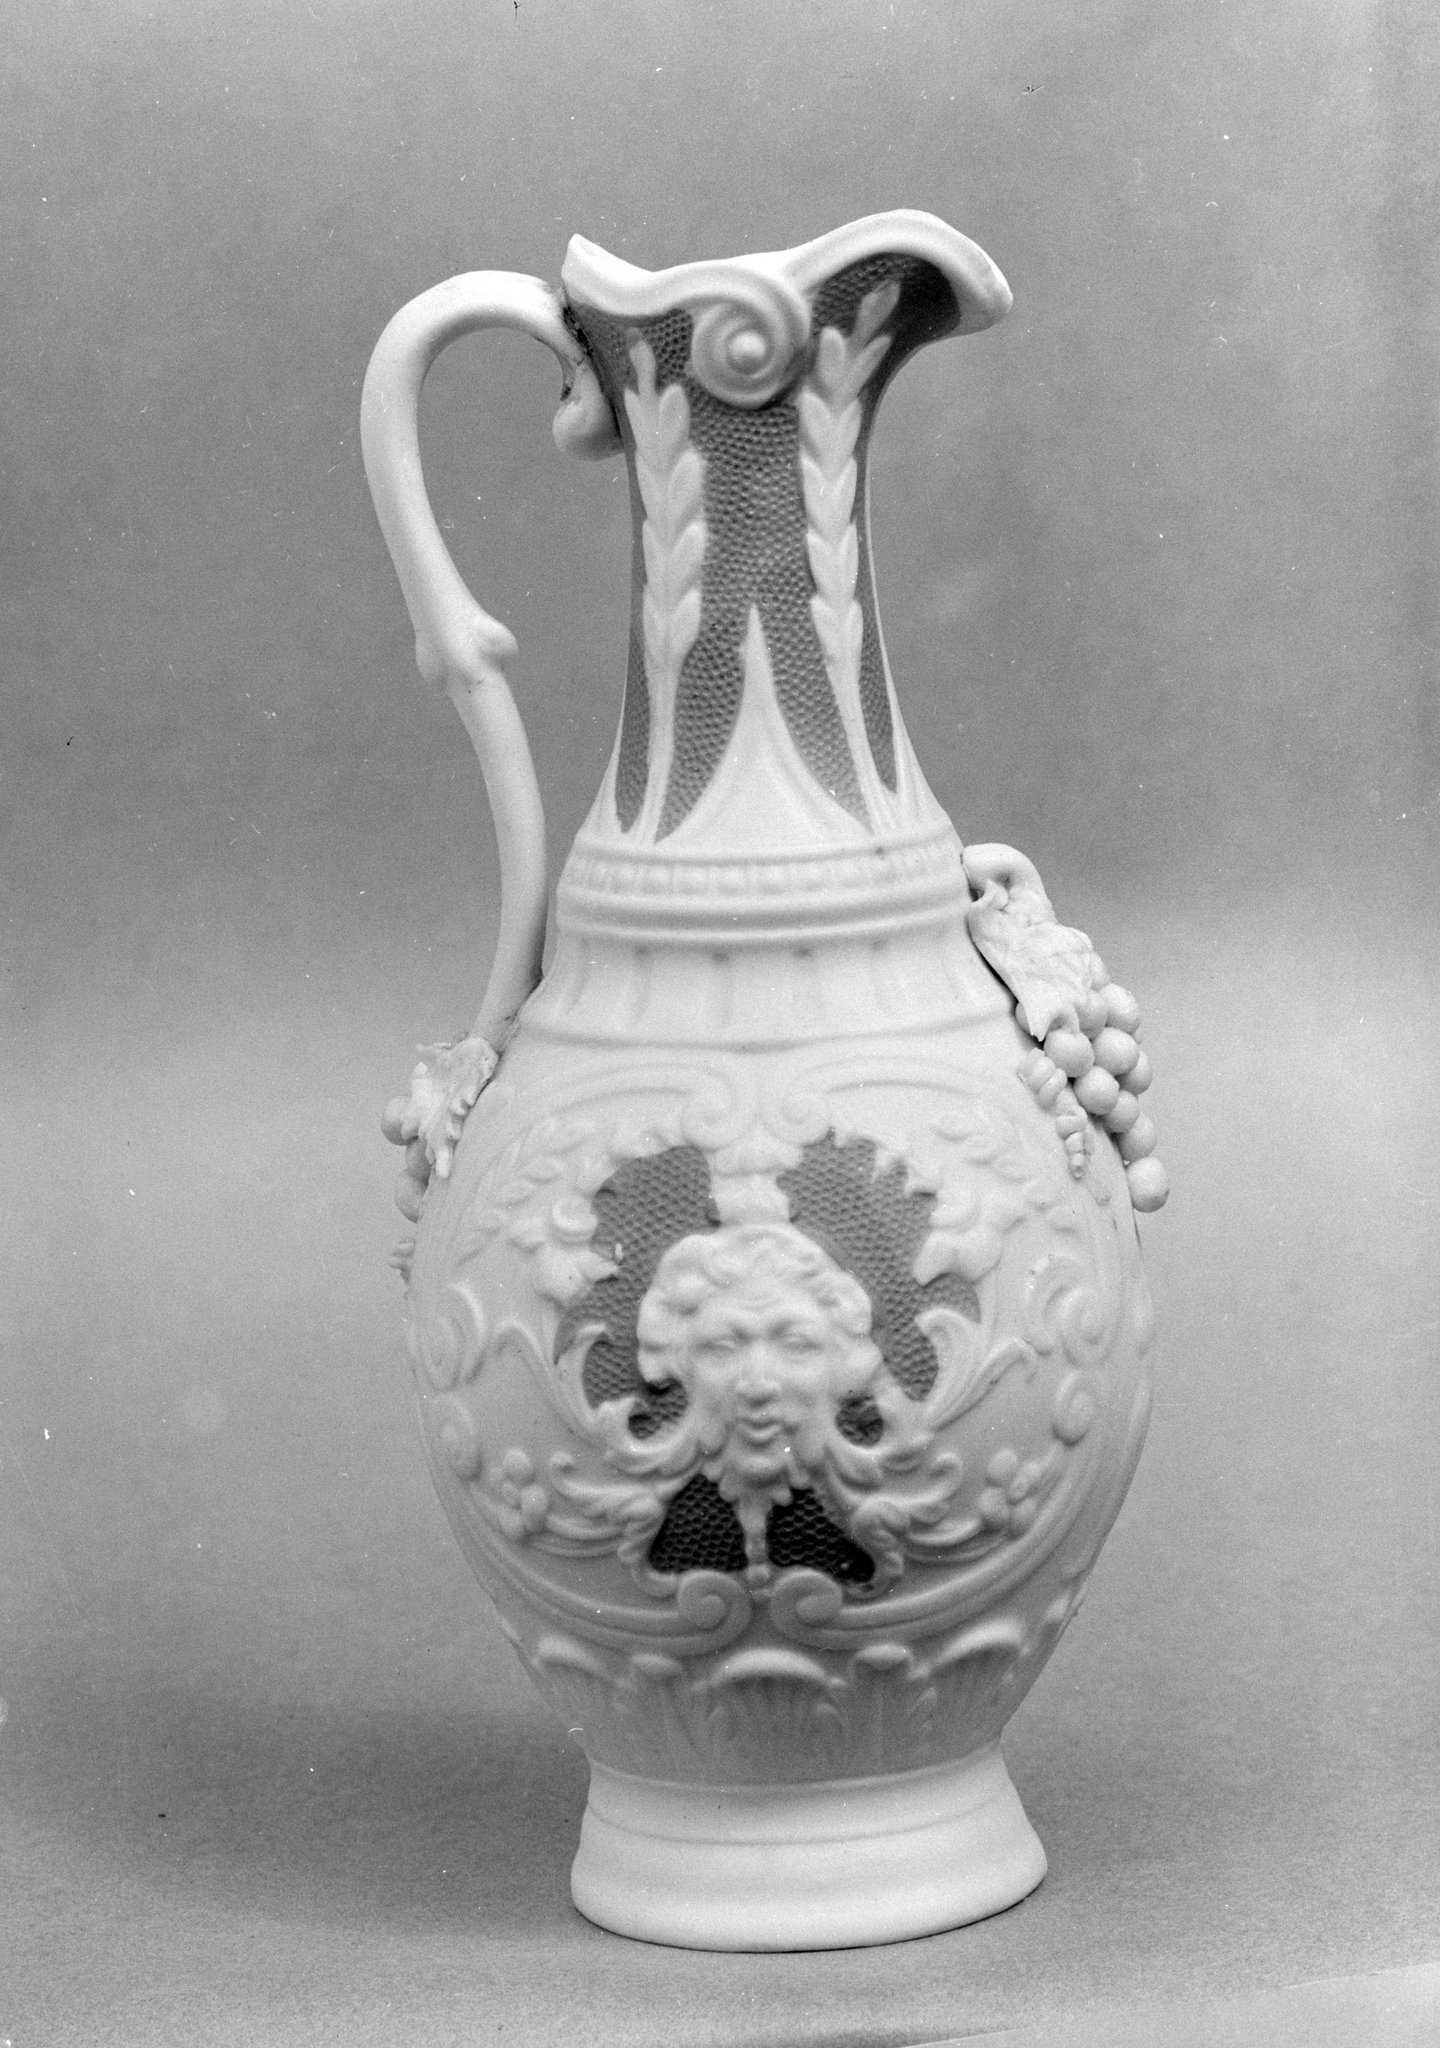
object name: ewer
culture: american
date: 1830-1870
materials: porcelain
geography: united states